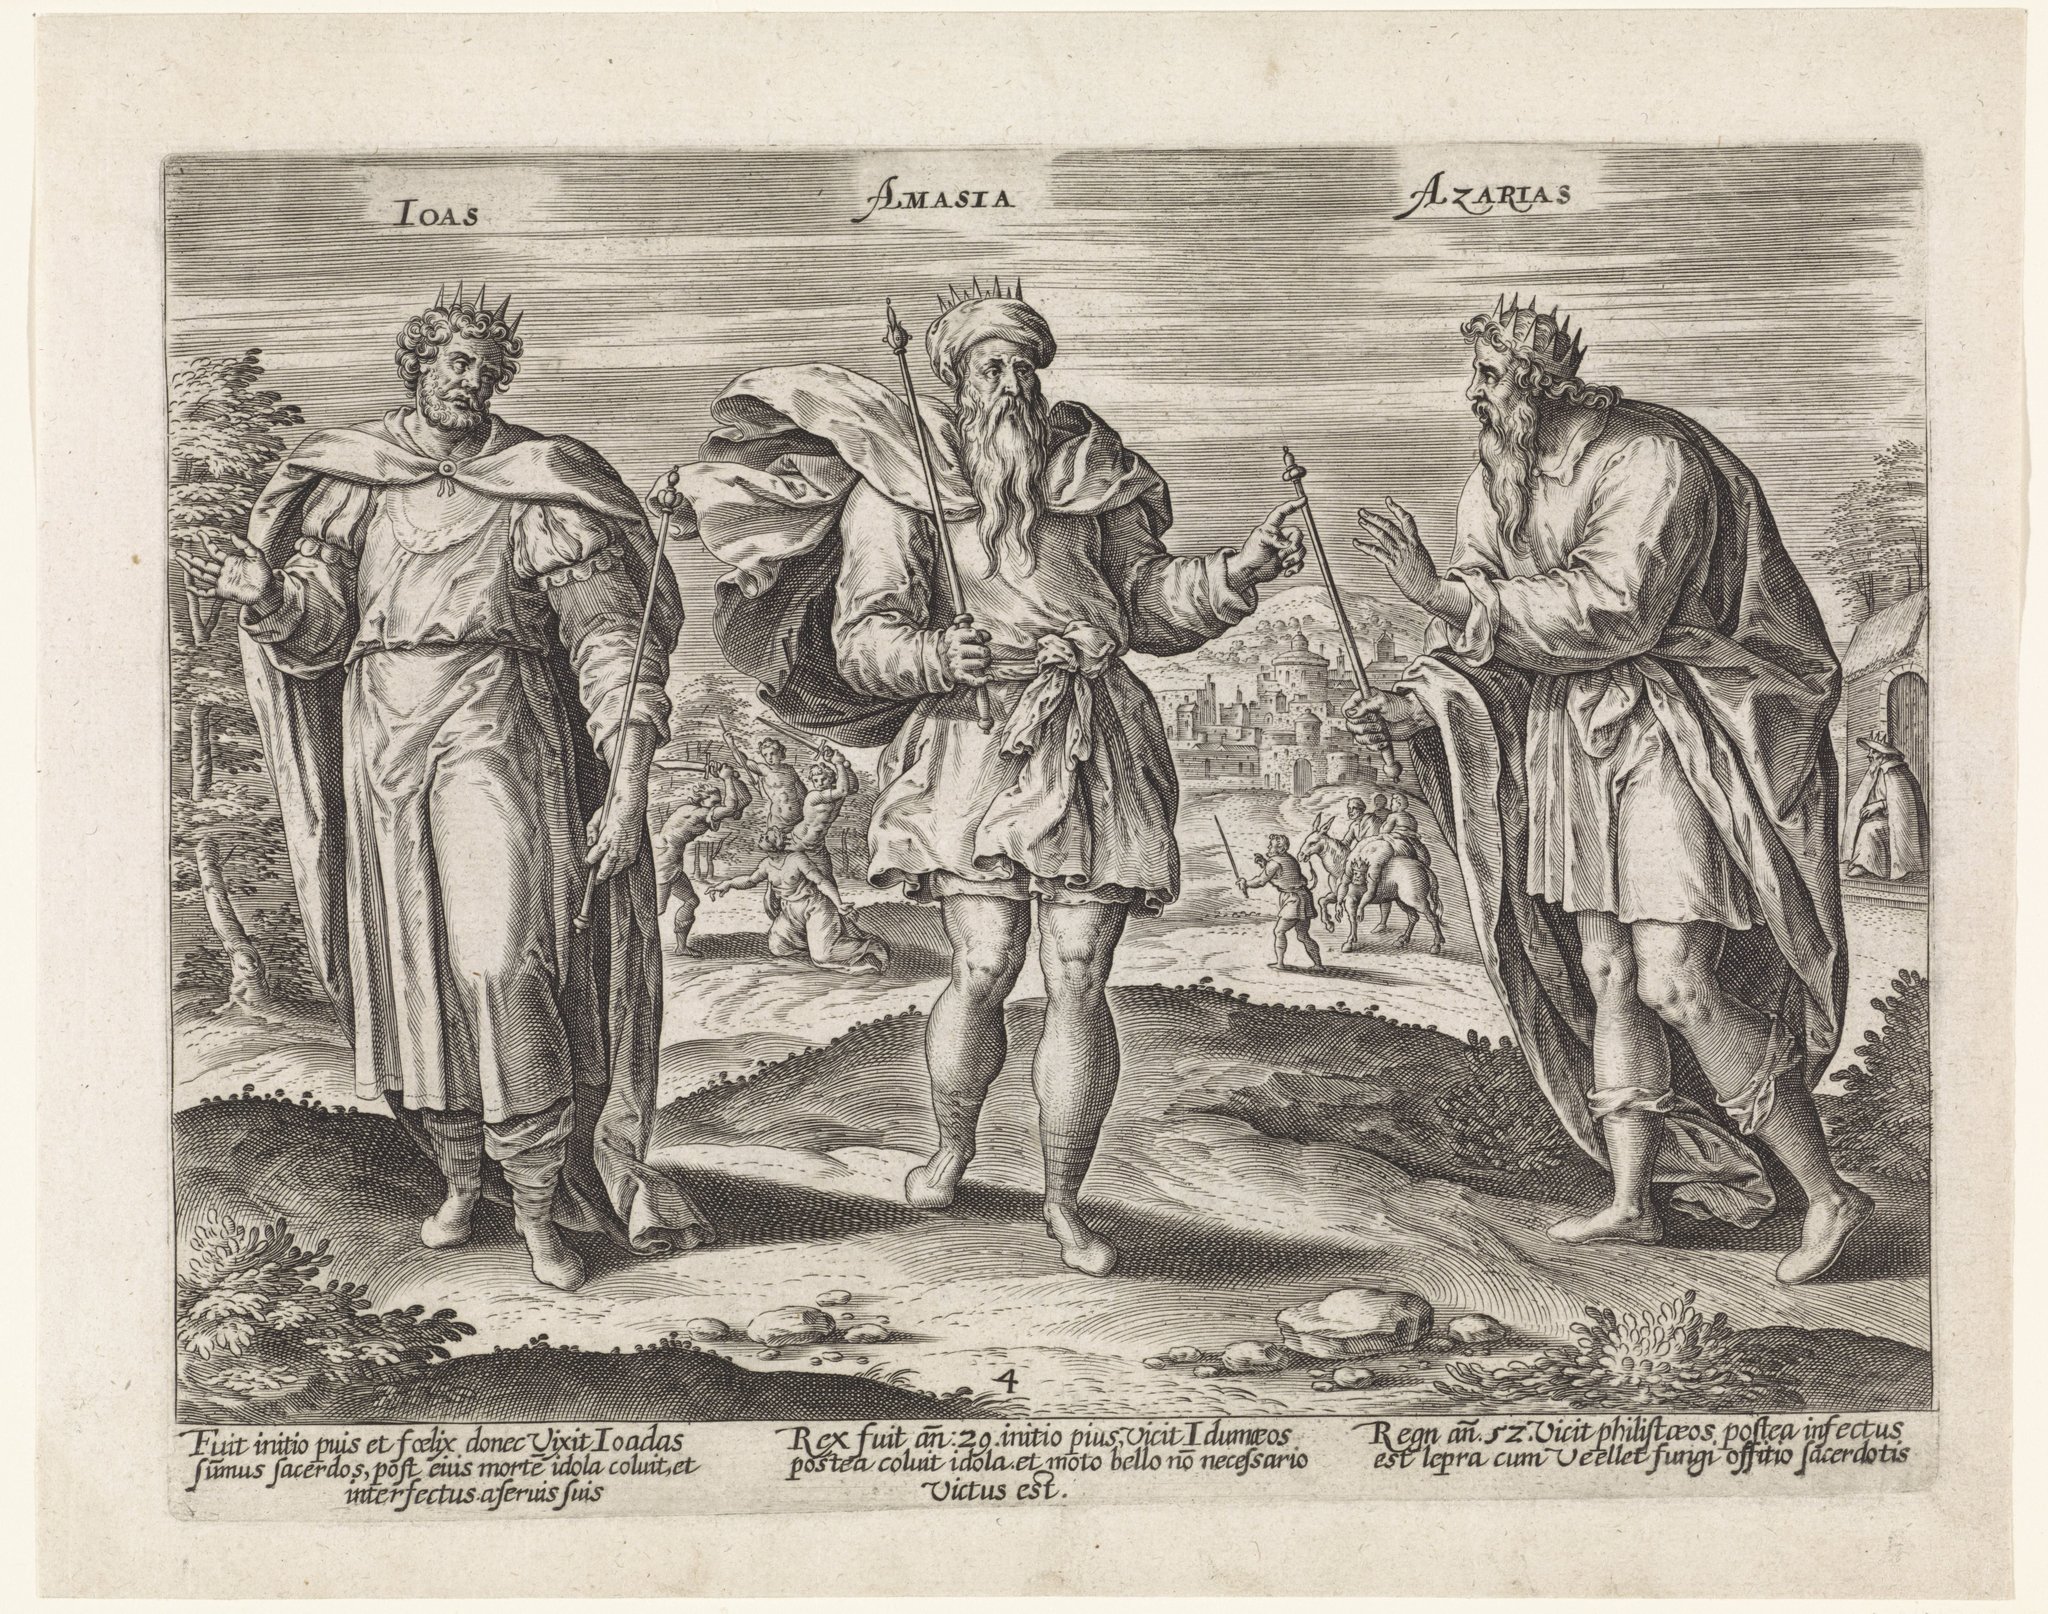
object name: print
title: Thesaurus sacrarum historiarum veteris testamenti (...)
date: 1585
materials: paper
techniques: engraving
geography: antwerp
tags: death of athalia: she is seized by soldiers, brought to the palace and killed at the horse gate, story of joash, son of ahaziah, king of judah (2 kings 11:4 - 12:21; 2 chronicles 23-24), amaziah is assassinated in lachish; his body is carried back to jerusalem on a horse, story of uzziah (azariah), son of amaziah, king of judah (2 kings 15:1-7; 2 chronicles 26), story of amaziah, son of joash, king of judah (2 kings 14:1-21; 2 chronicles 25), kings of israel and judah ~ the old testament (not in biblical context)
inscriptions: collector's mark: Lugt 2228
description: De koningen Joas, Amasja en Azarja. Op de achtergrond enkele belangrijke gebeurtenissen uit hun leven. Links op de achtergrond wordt Joas' voorganger koningin Atalja ter dood gebracht. Midden op de achtergrond wordt de vermoorde koning Amasja te paard naar Jeruzalem gebracht. Rechts op de achtergrond zit koning Azarja bedekt bij een poort. Hij leefde in afzondering omdat hij leed aan huidvraat. Onder de voorstelling toelichtingen in het Latijn.